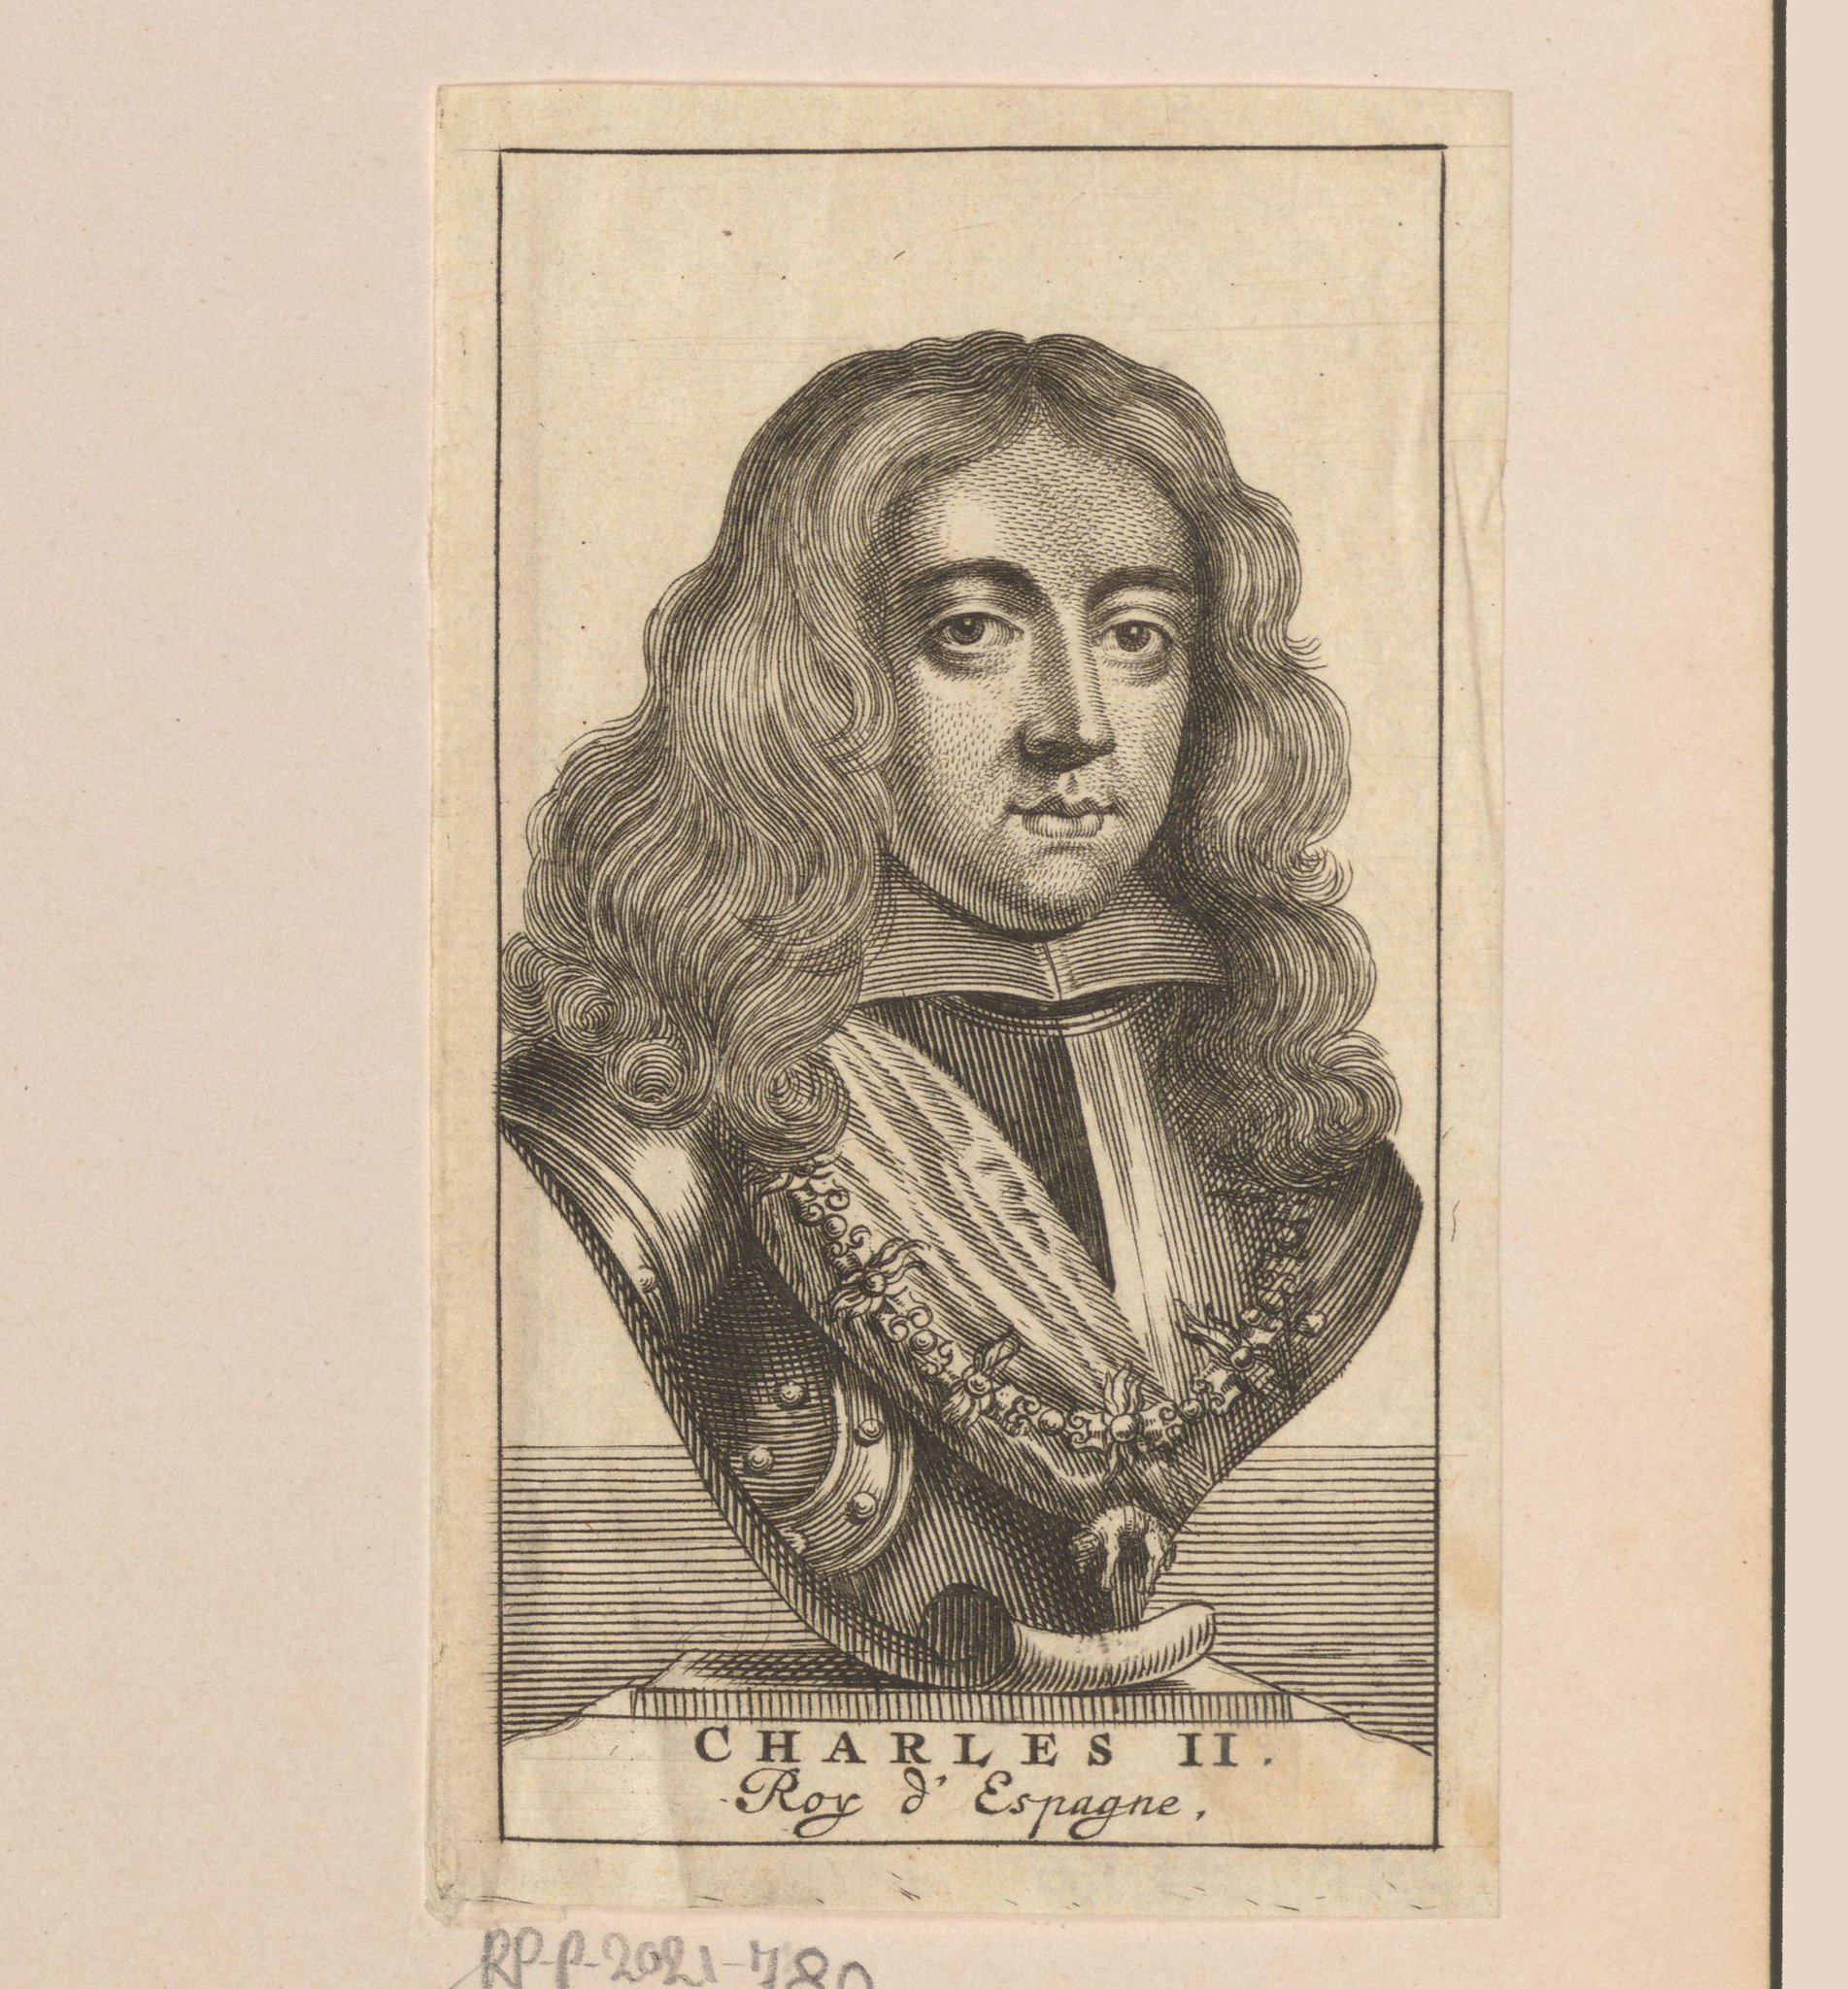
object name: print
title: Portretbuste van Karel II, koning van Spanje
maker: Anonymous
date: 1700-1799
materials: paper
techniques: engraving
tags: karel ii (koning van spanje), historical persons, knighthood order of the golden fleece, king